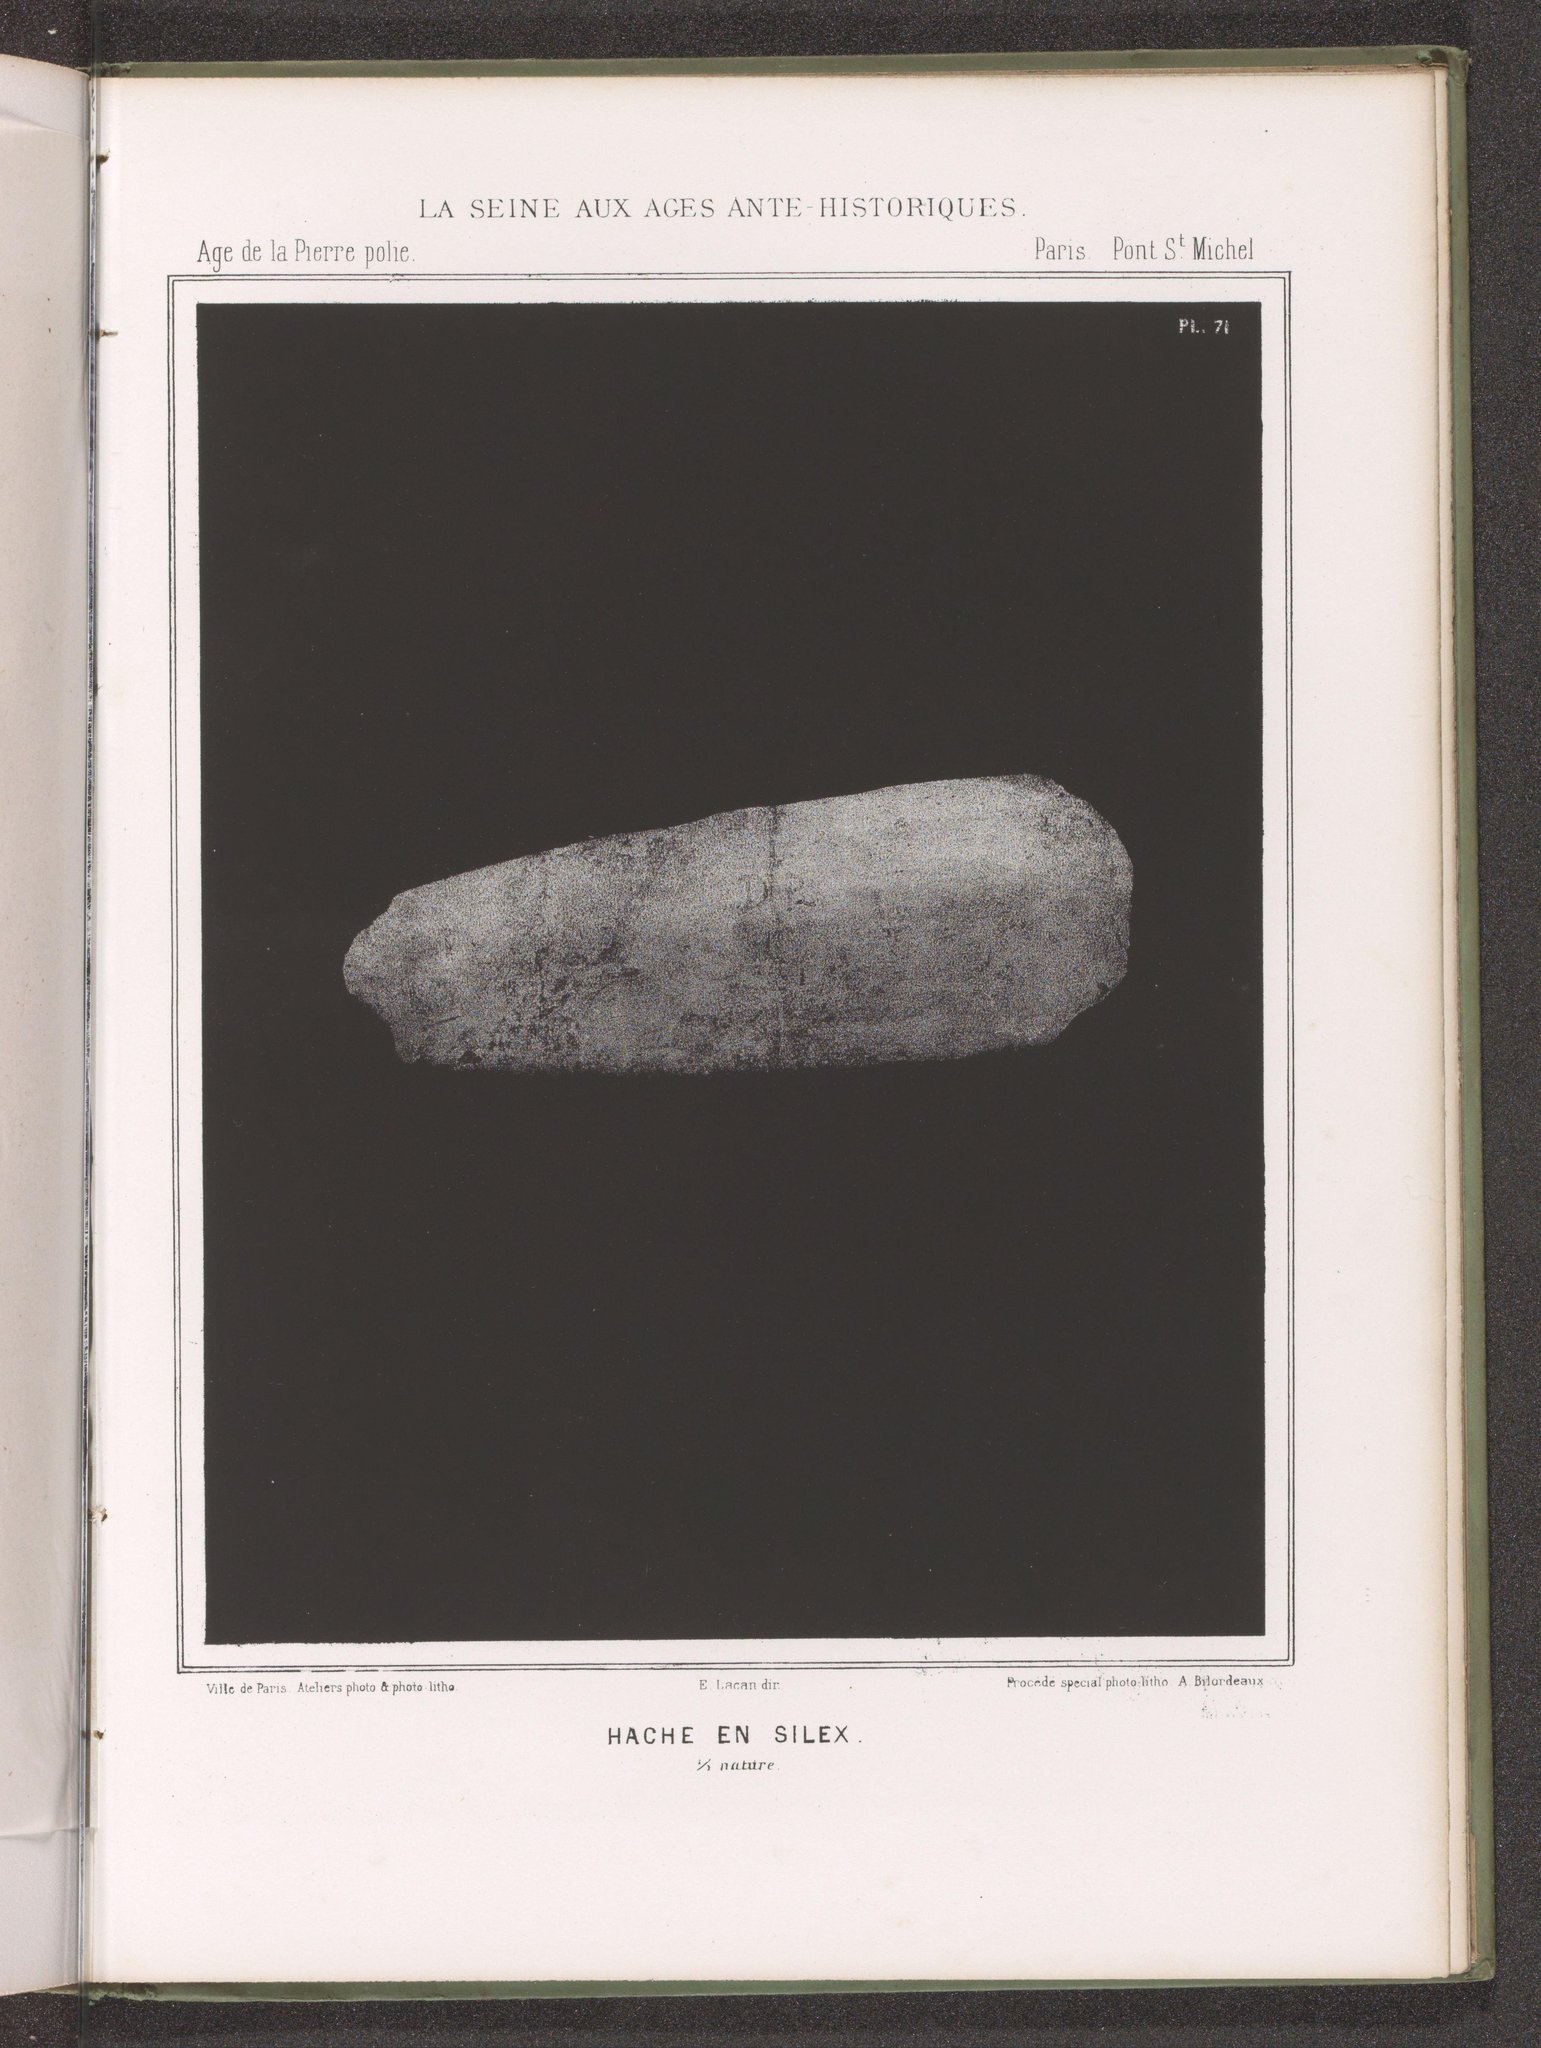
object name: photomechanical print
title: HACHE EN SILEX. 1/2 nature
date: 1860-1869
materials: paper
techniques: photolithography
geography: france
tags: animals (+ skeleton of an animal), palaeontology, france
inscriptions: number: ‘Pl. 71’, inscription: ‘Ville de Paris Ateliers photo & photo-litho. E. Lacan dir. Procédé spécial photo-litho A. Bilordeaux’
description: Voor plek prent in boek: zie nummer onder 'Opschriften / Merken'.